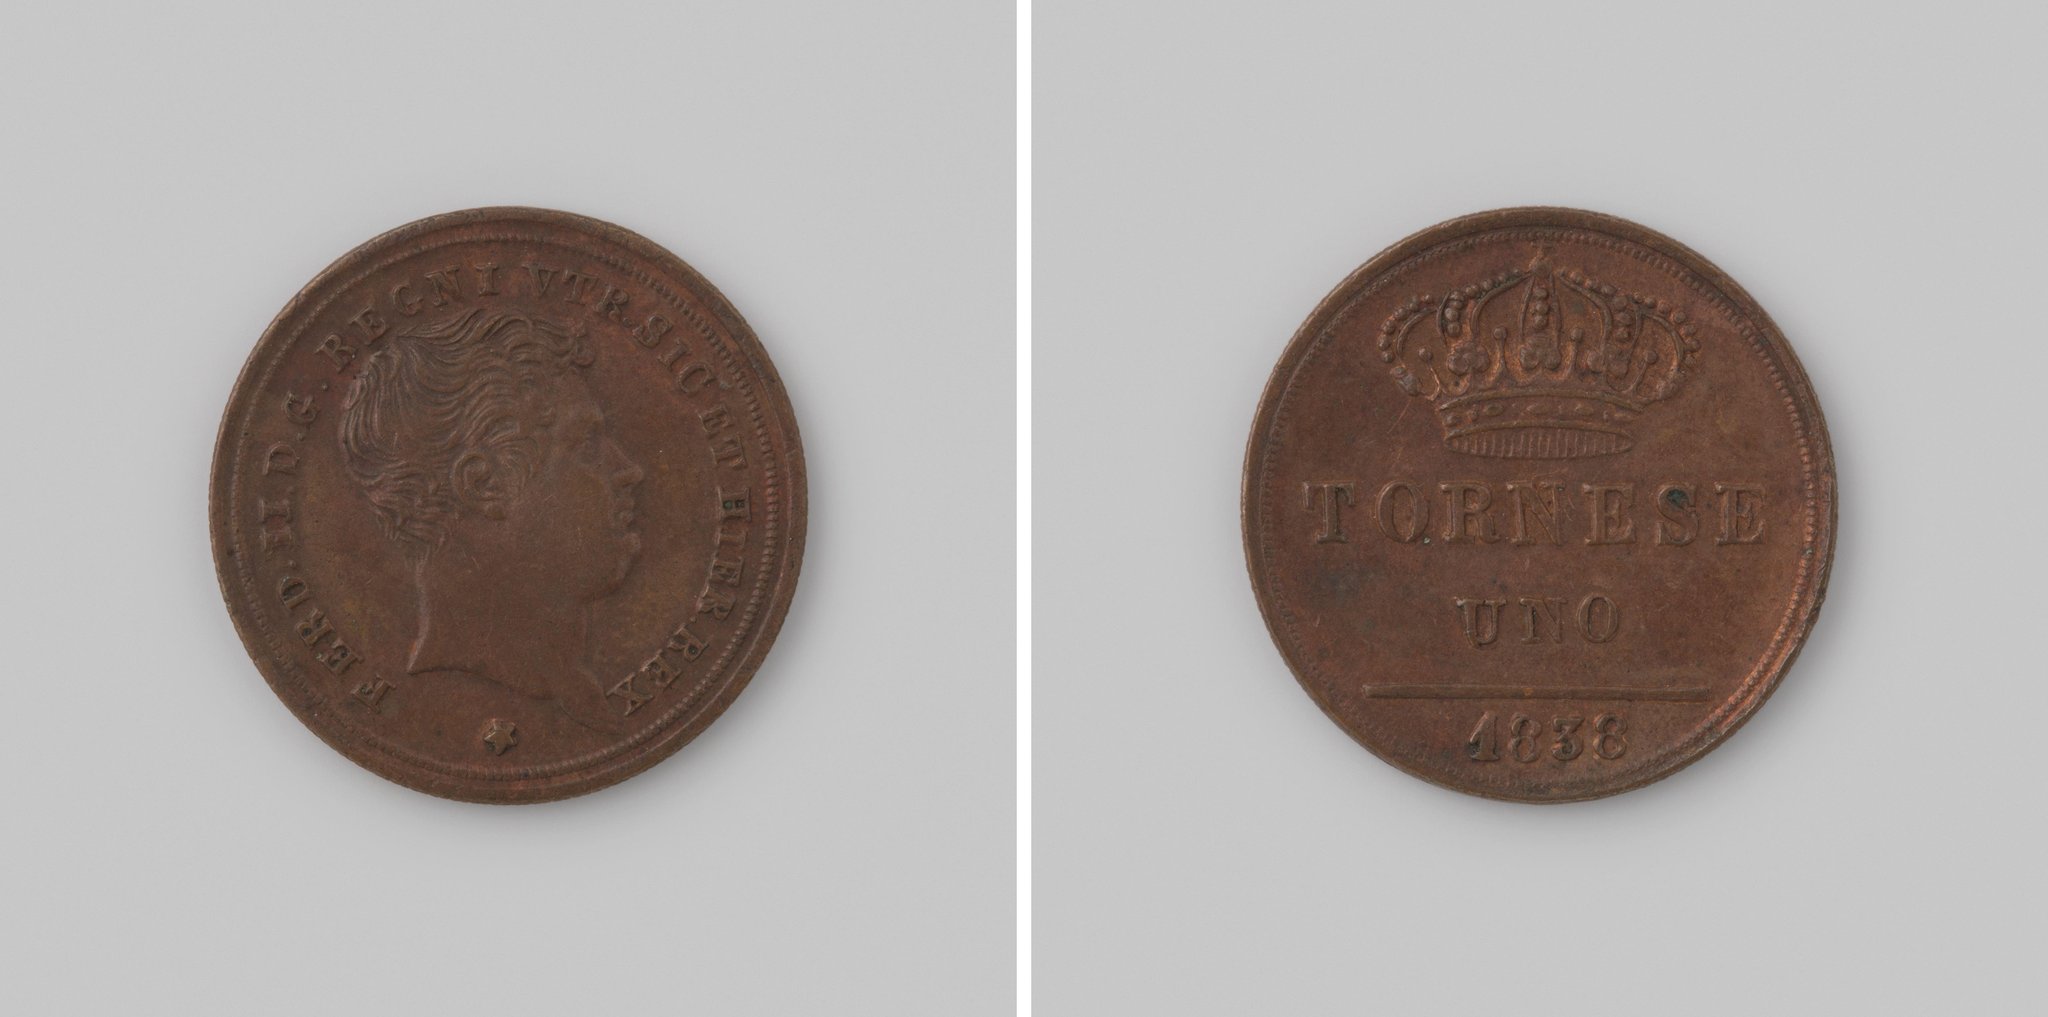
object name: coin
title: Koninkrijk Napels van de beide Siciliën, Ferdinando II, tornese, 1838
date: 1838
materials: copper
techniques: striking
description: Koperen munt. Voorzijde: hoofd naar rechts. Keerzijde: kroon, waaronder in twee regels waarde-aanduiding. Jaartal in afsnede onderaan. Kartelrand.